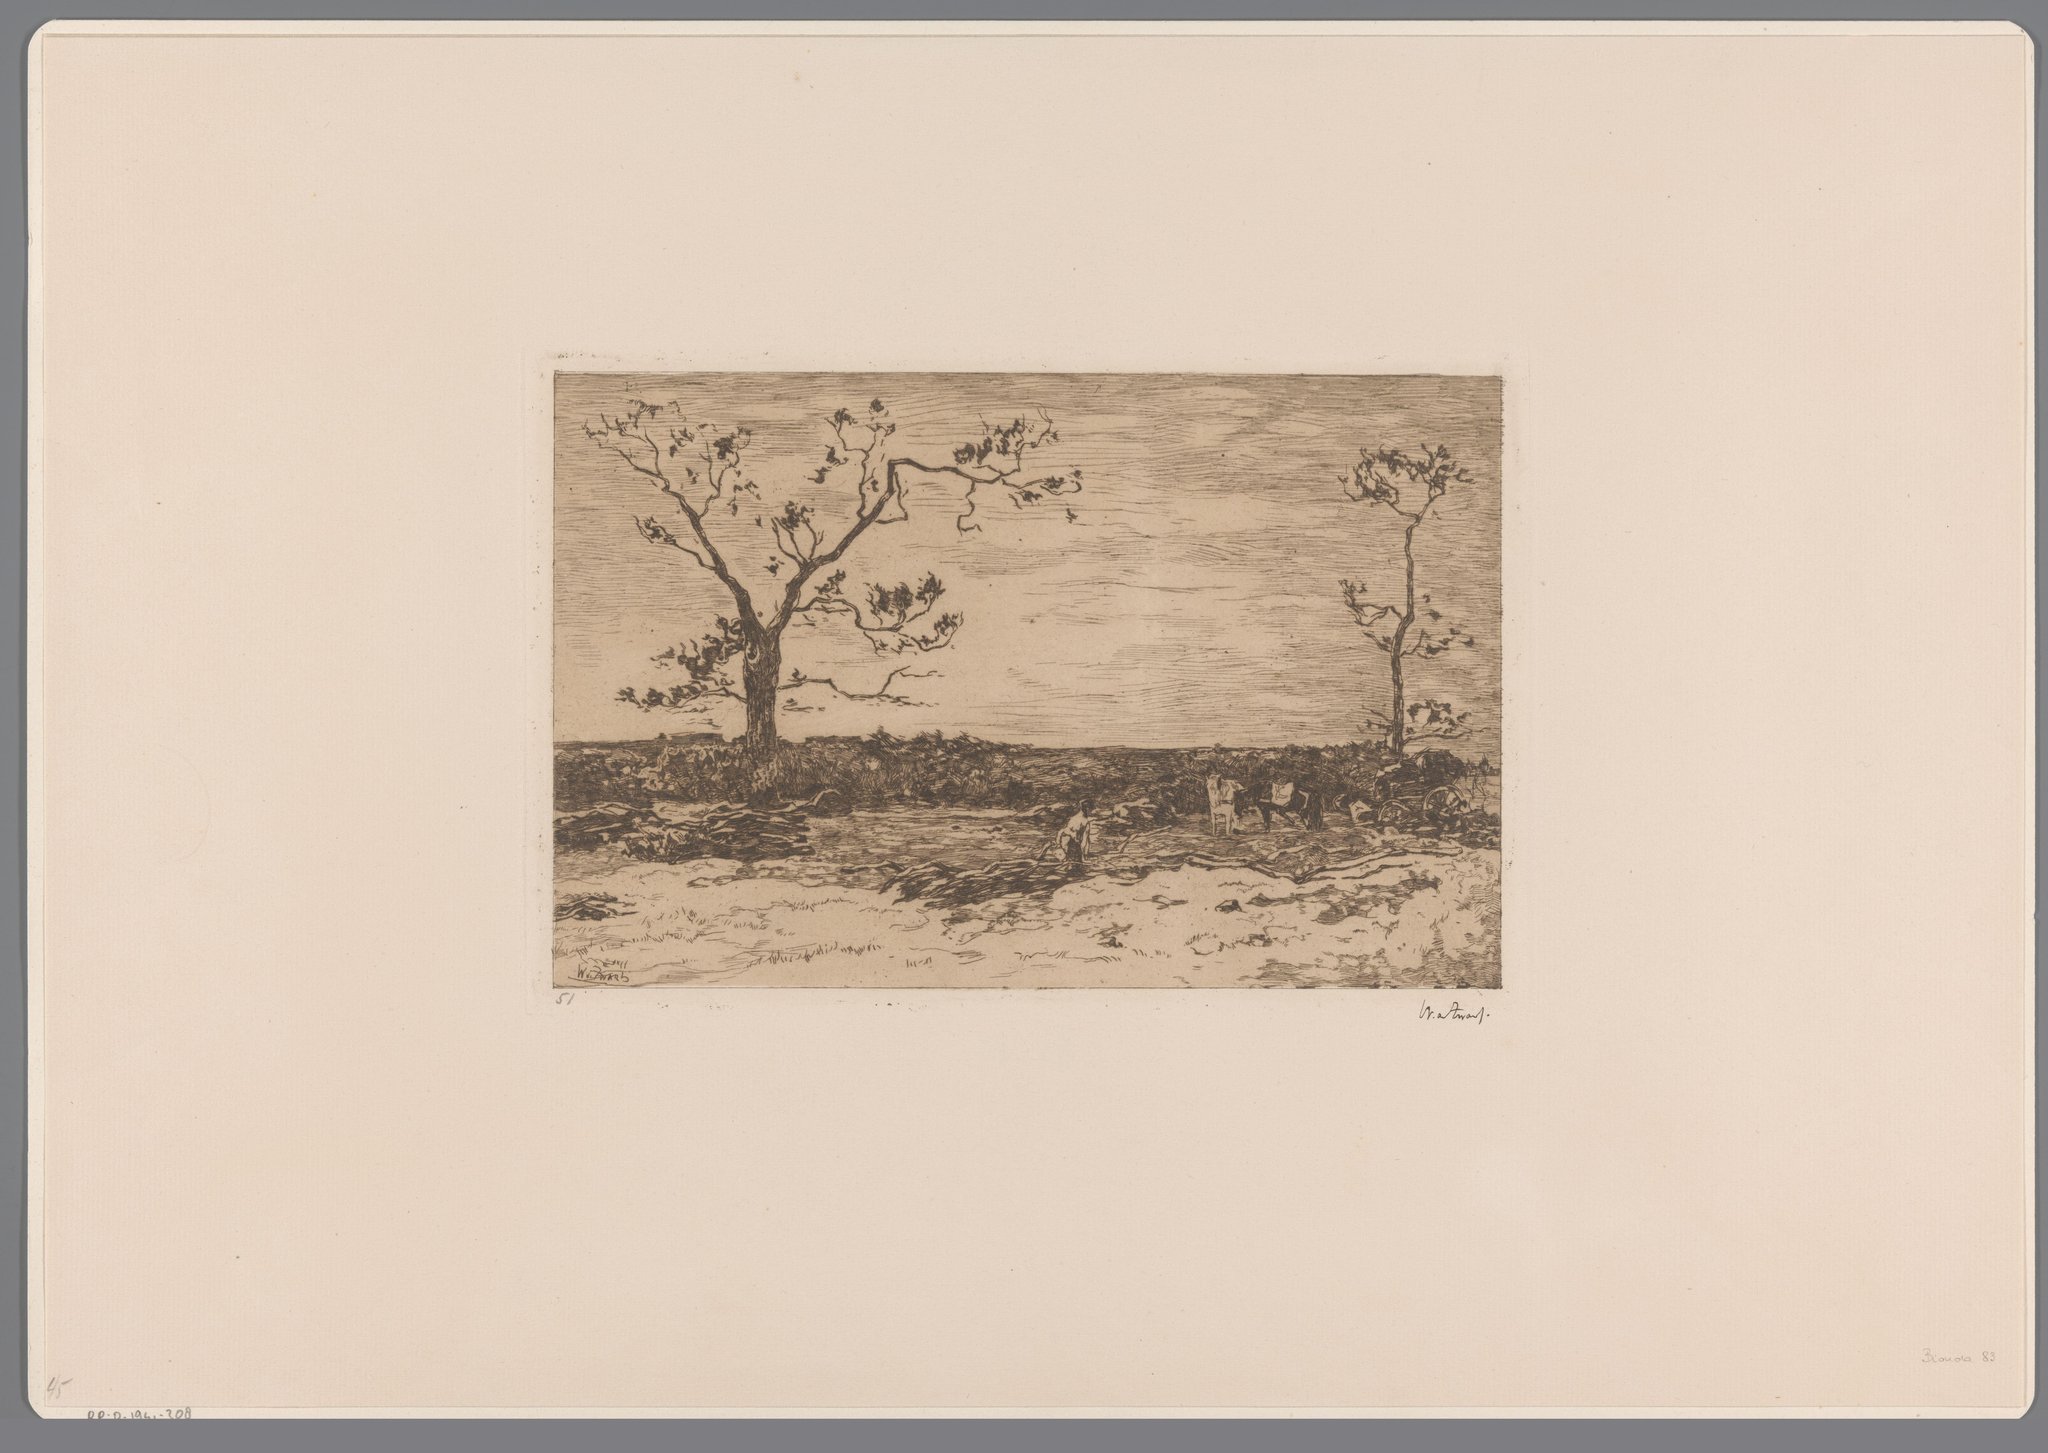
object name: print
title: Hakhout laden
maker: willem de zwart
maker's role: draughtsman, painter, print maker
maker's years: 1862-1931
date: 1896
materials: paper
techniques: etching, intaglio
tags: forester, trees, (farm) wagon, freight wagon, cart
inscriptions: collector's mark: Lugt 2760, collector's mark: Lugt 2228